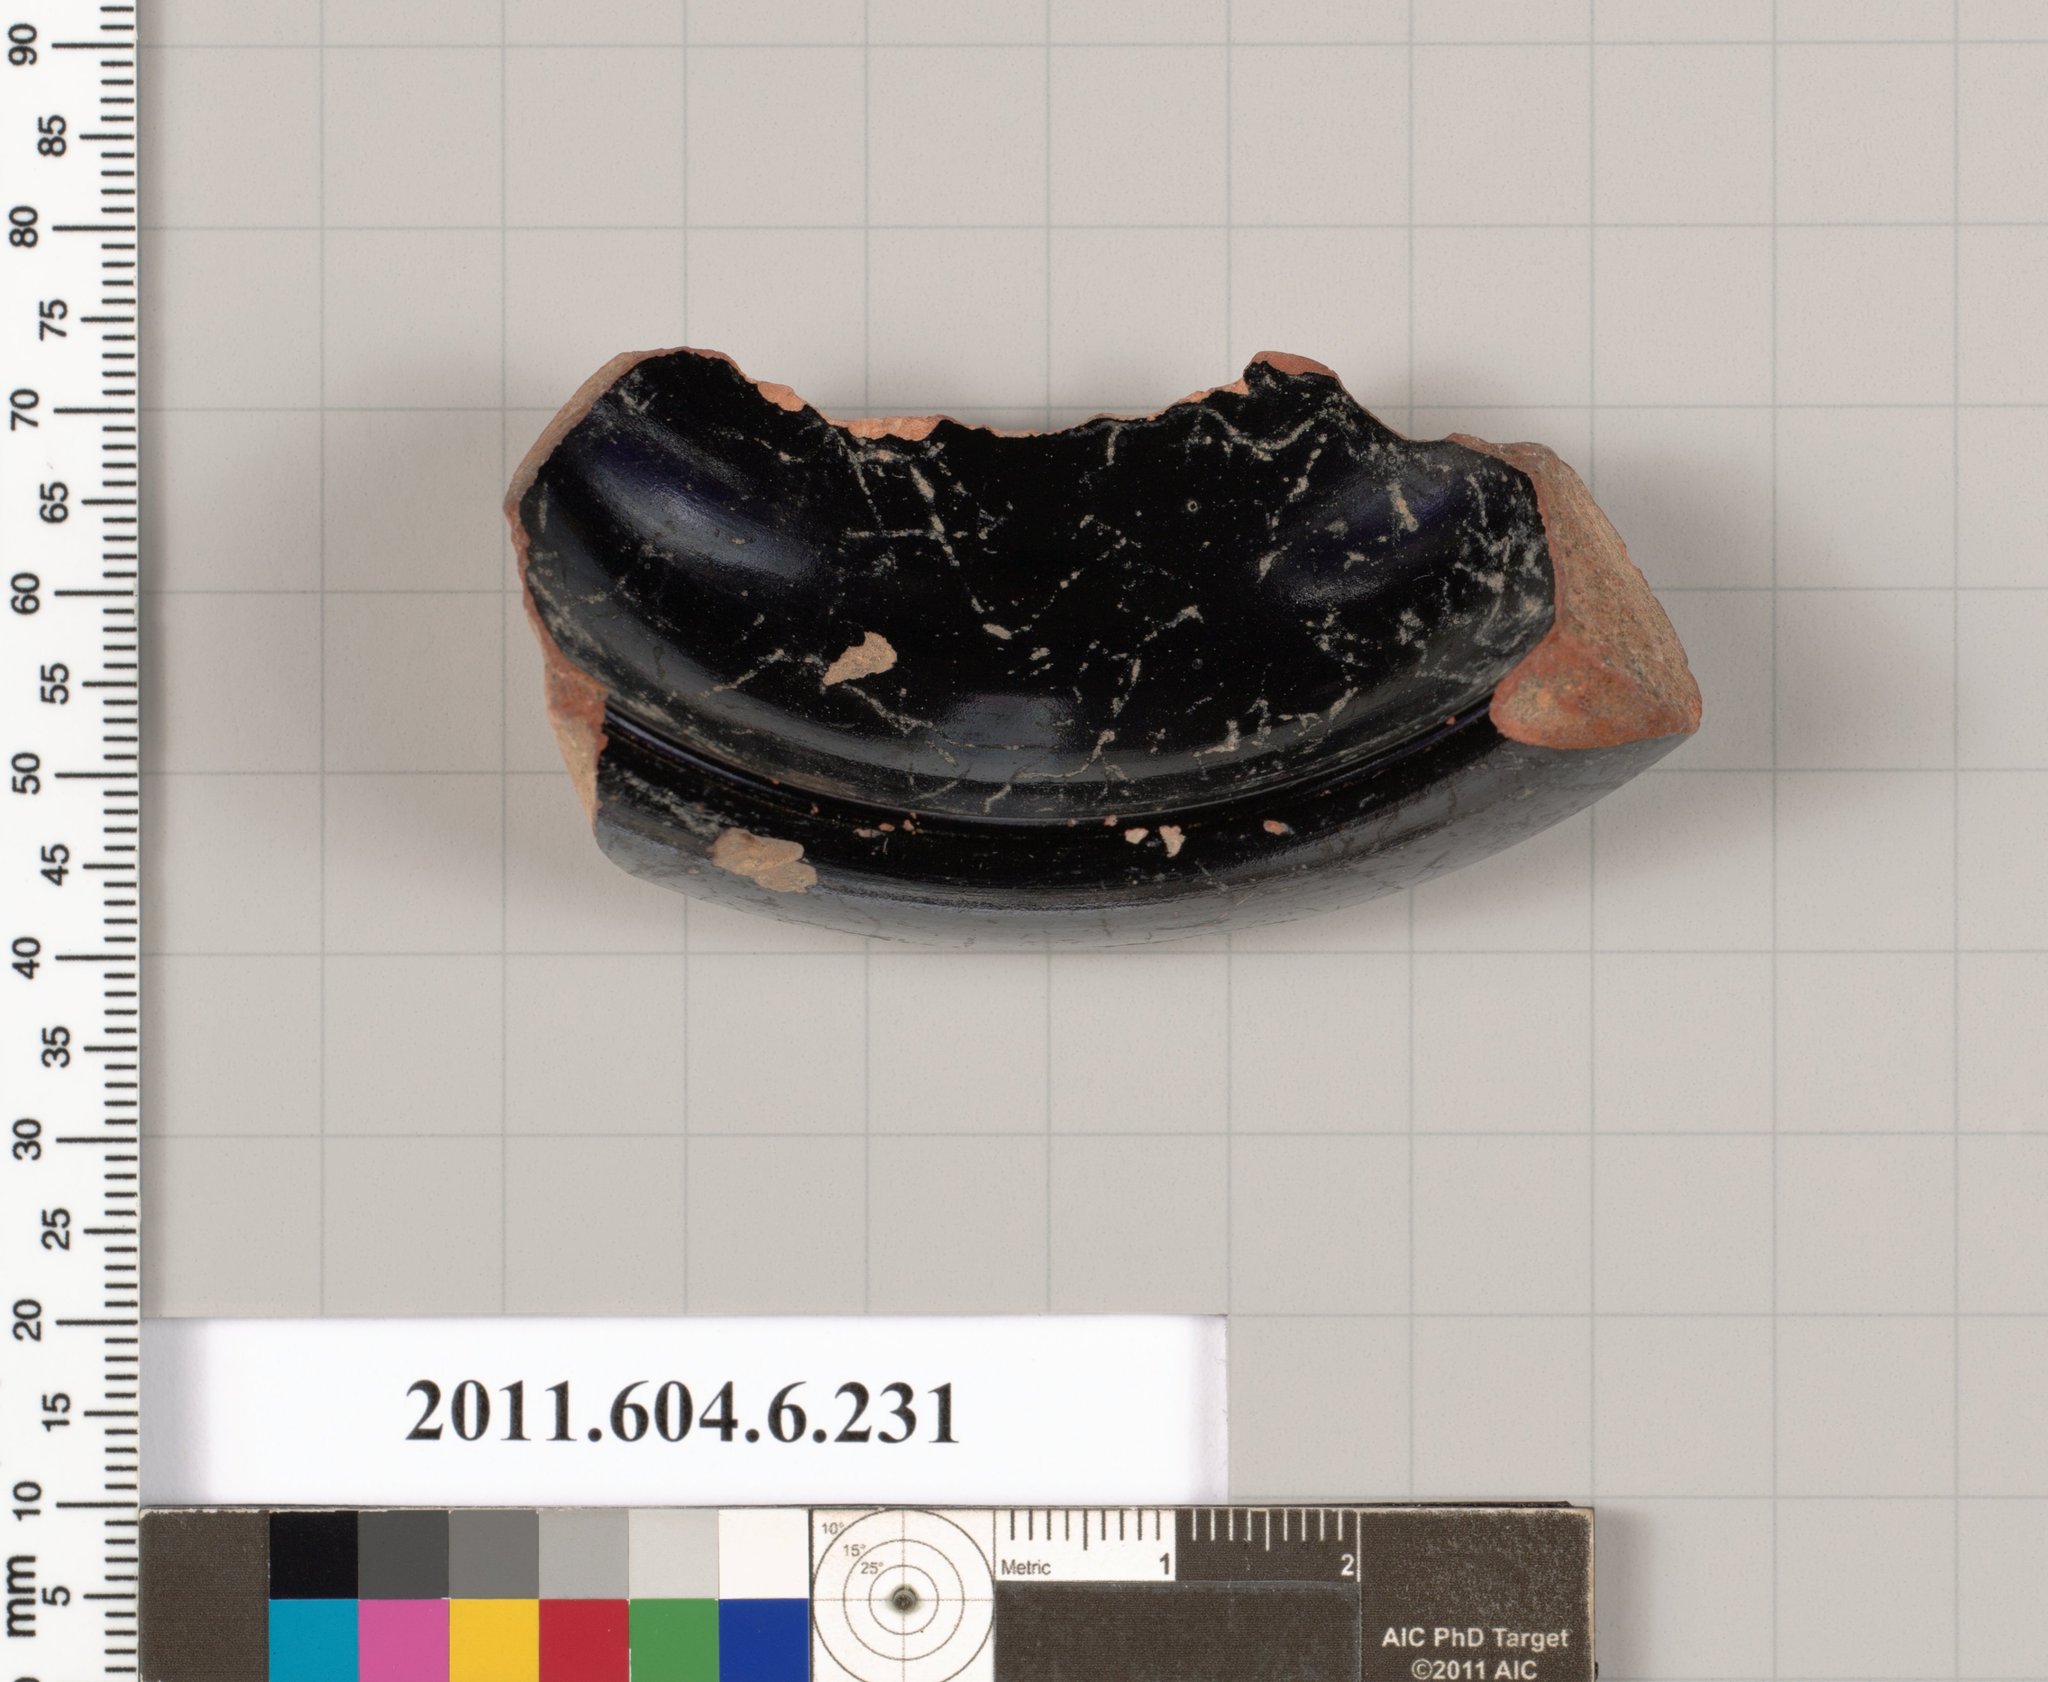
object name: salt cellar fragment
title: Terracotta fragment of a salt cellar?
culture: greek, attic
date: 500-451 BCE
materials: terracotta